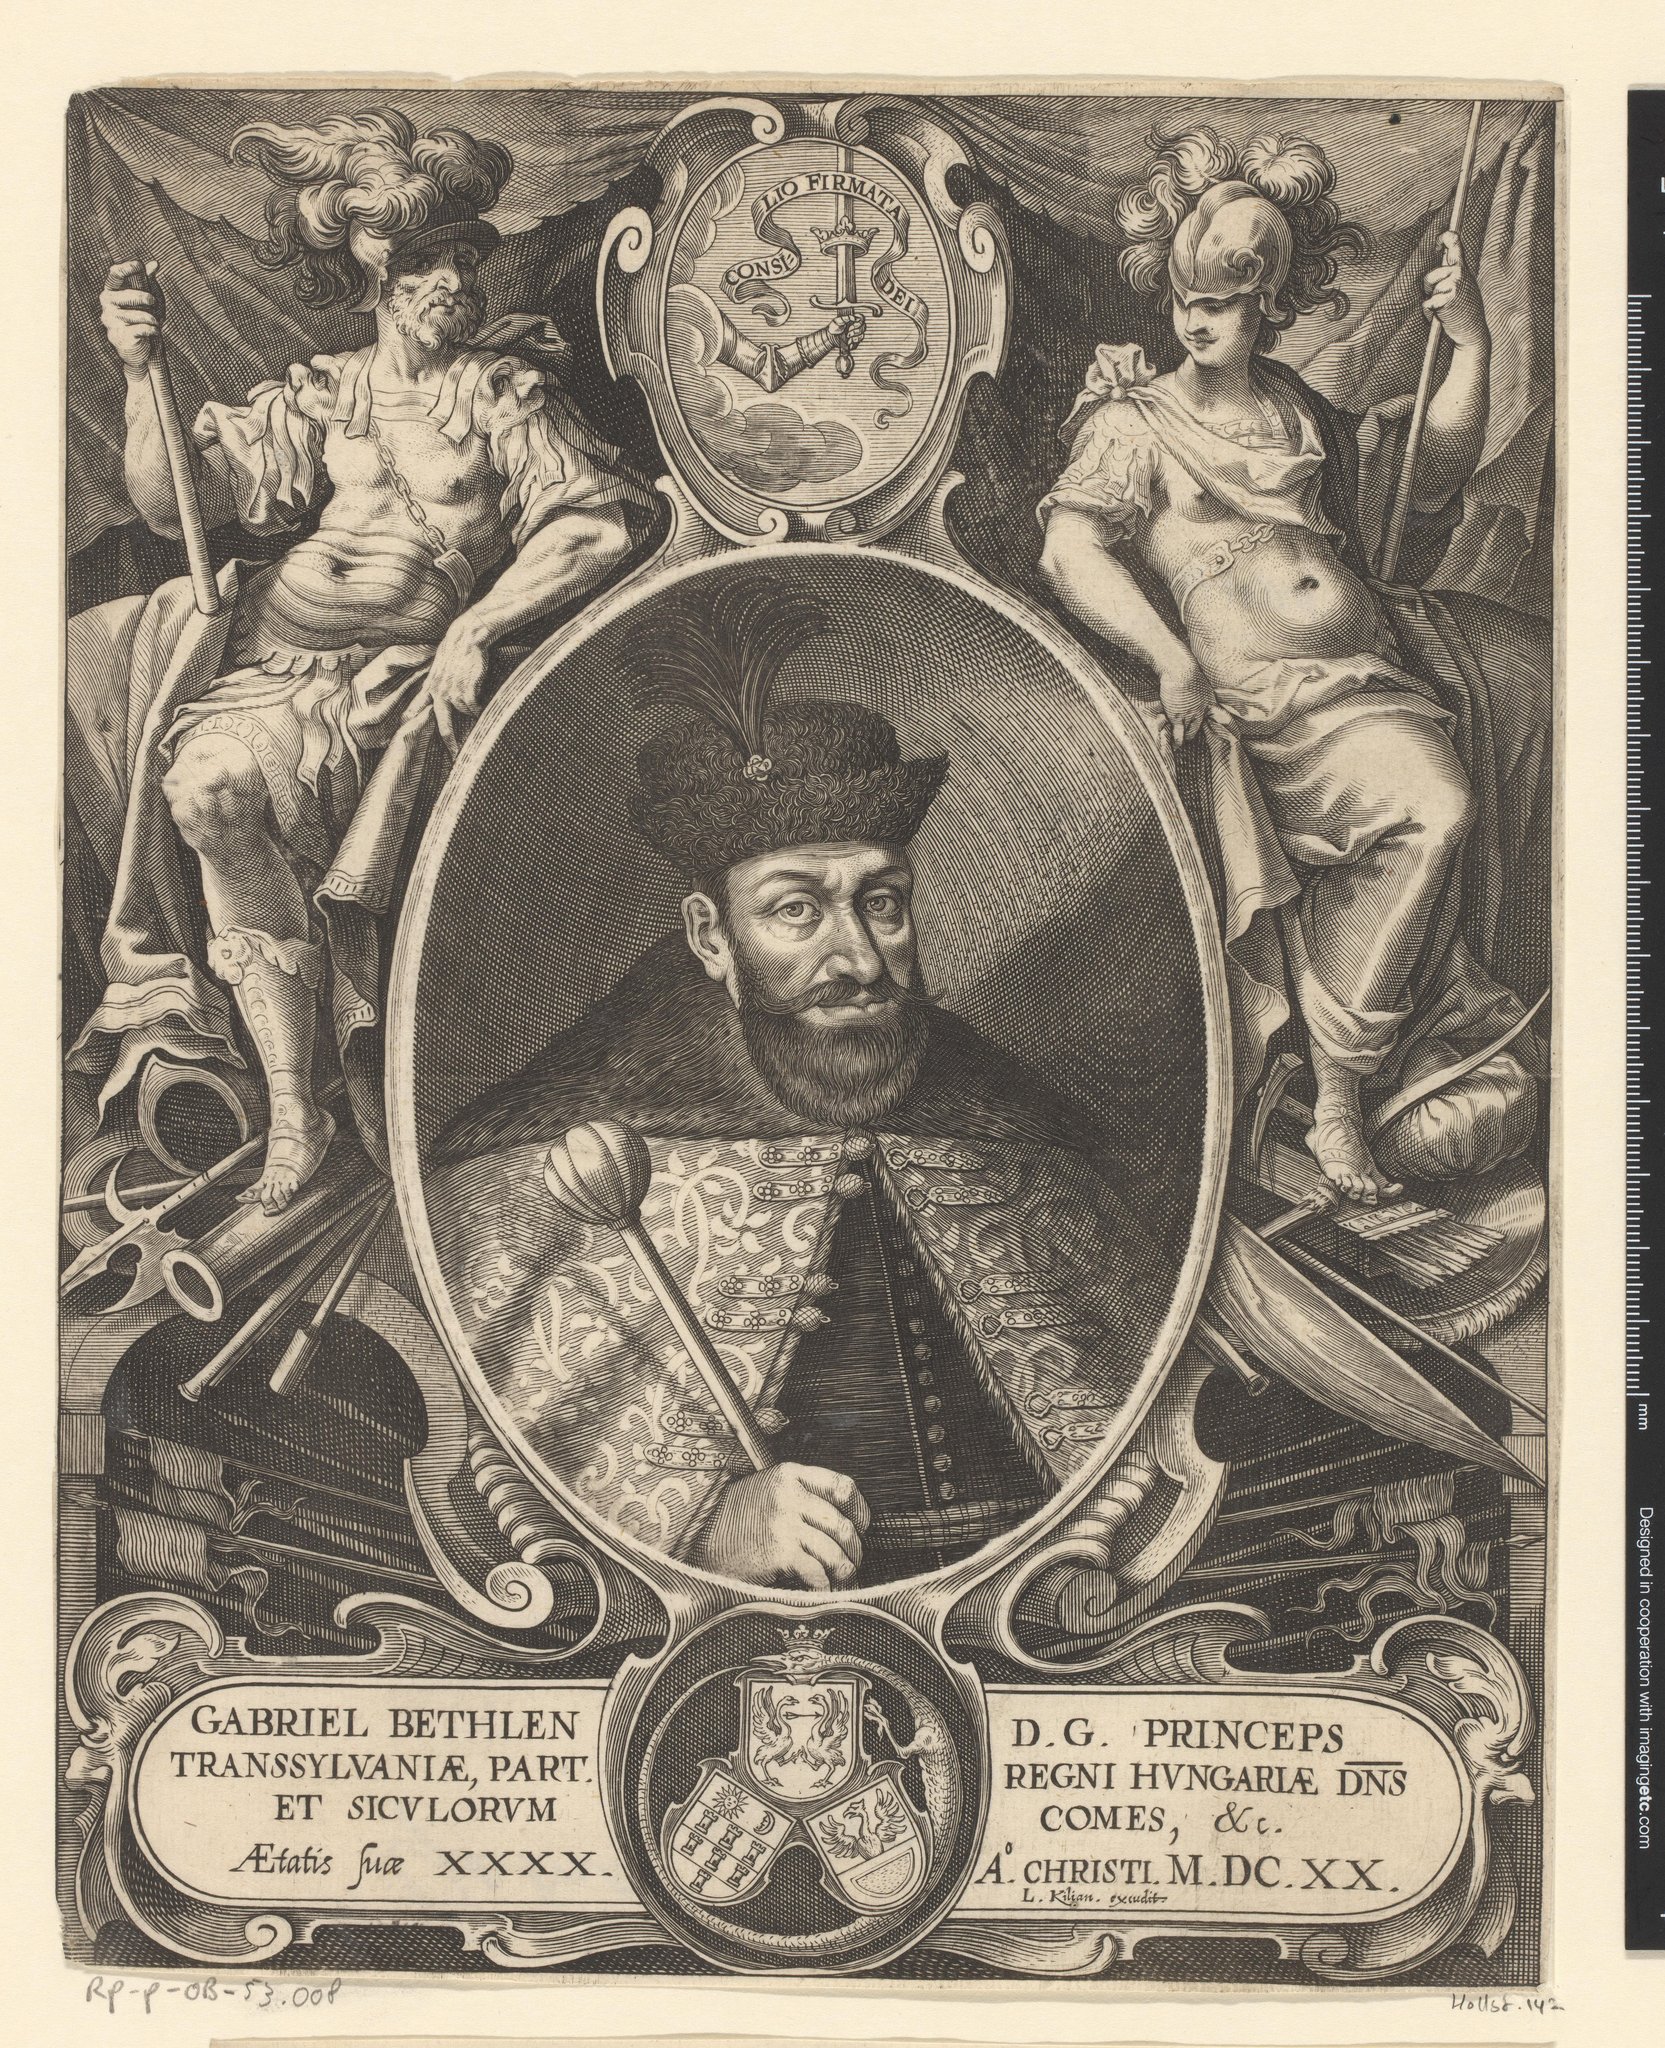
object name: print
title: Portret van Gábor Bethlen op 40-jarige leeftijd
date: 1620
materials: paper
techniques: engraving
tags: historical persons, ruler, sovereign, symbols, allegories of war; 'guerra' (ripa)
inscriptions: collector's mark: Lugt 2228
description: Allegorie op strijd en oorlogsvoering aan weerszijden van het portret. Tekst in het Latijn in de omlijsting en in de cartouche.